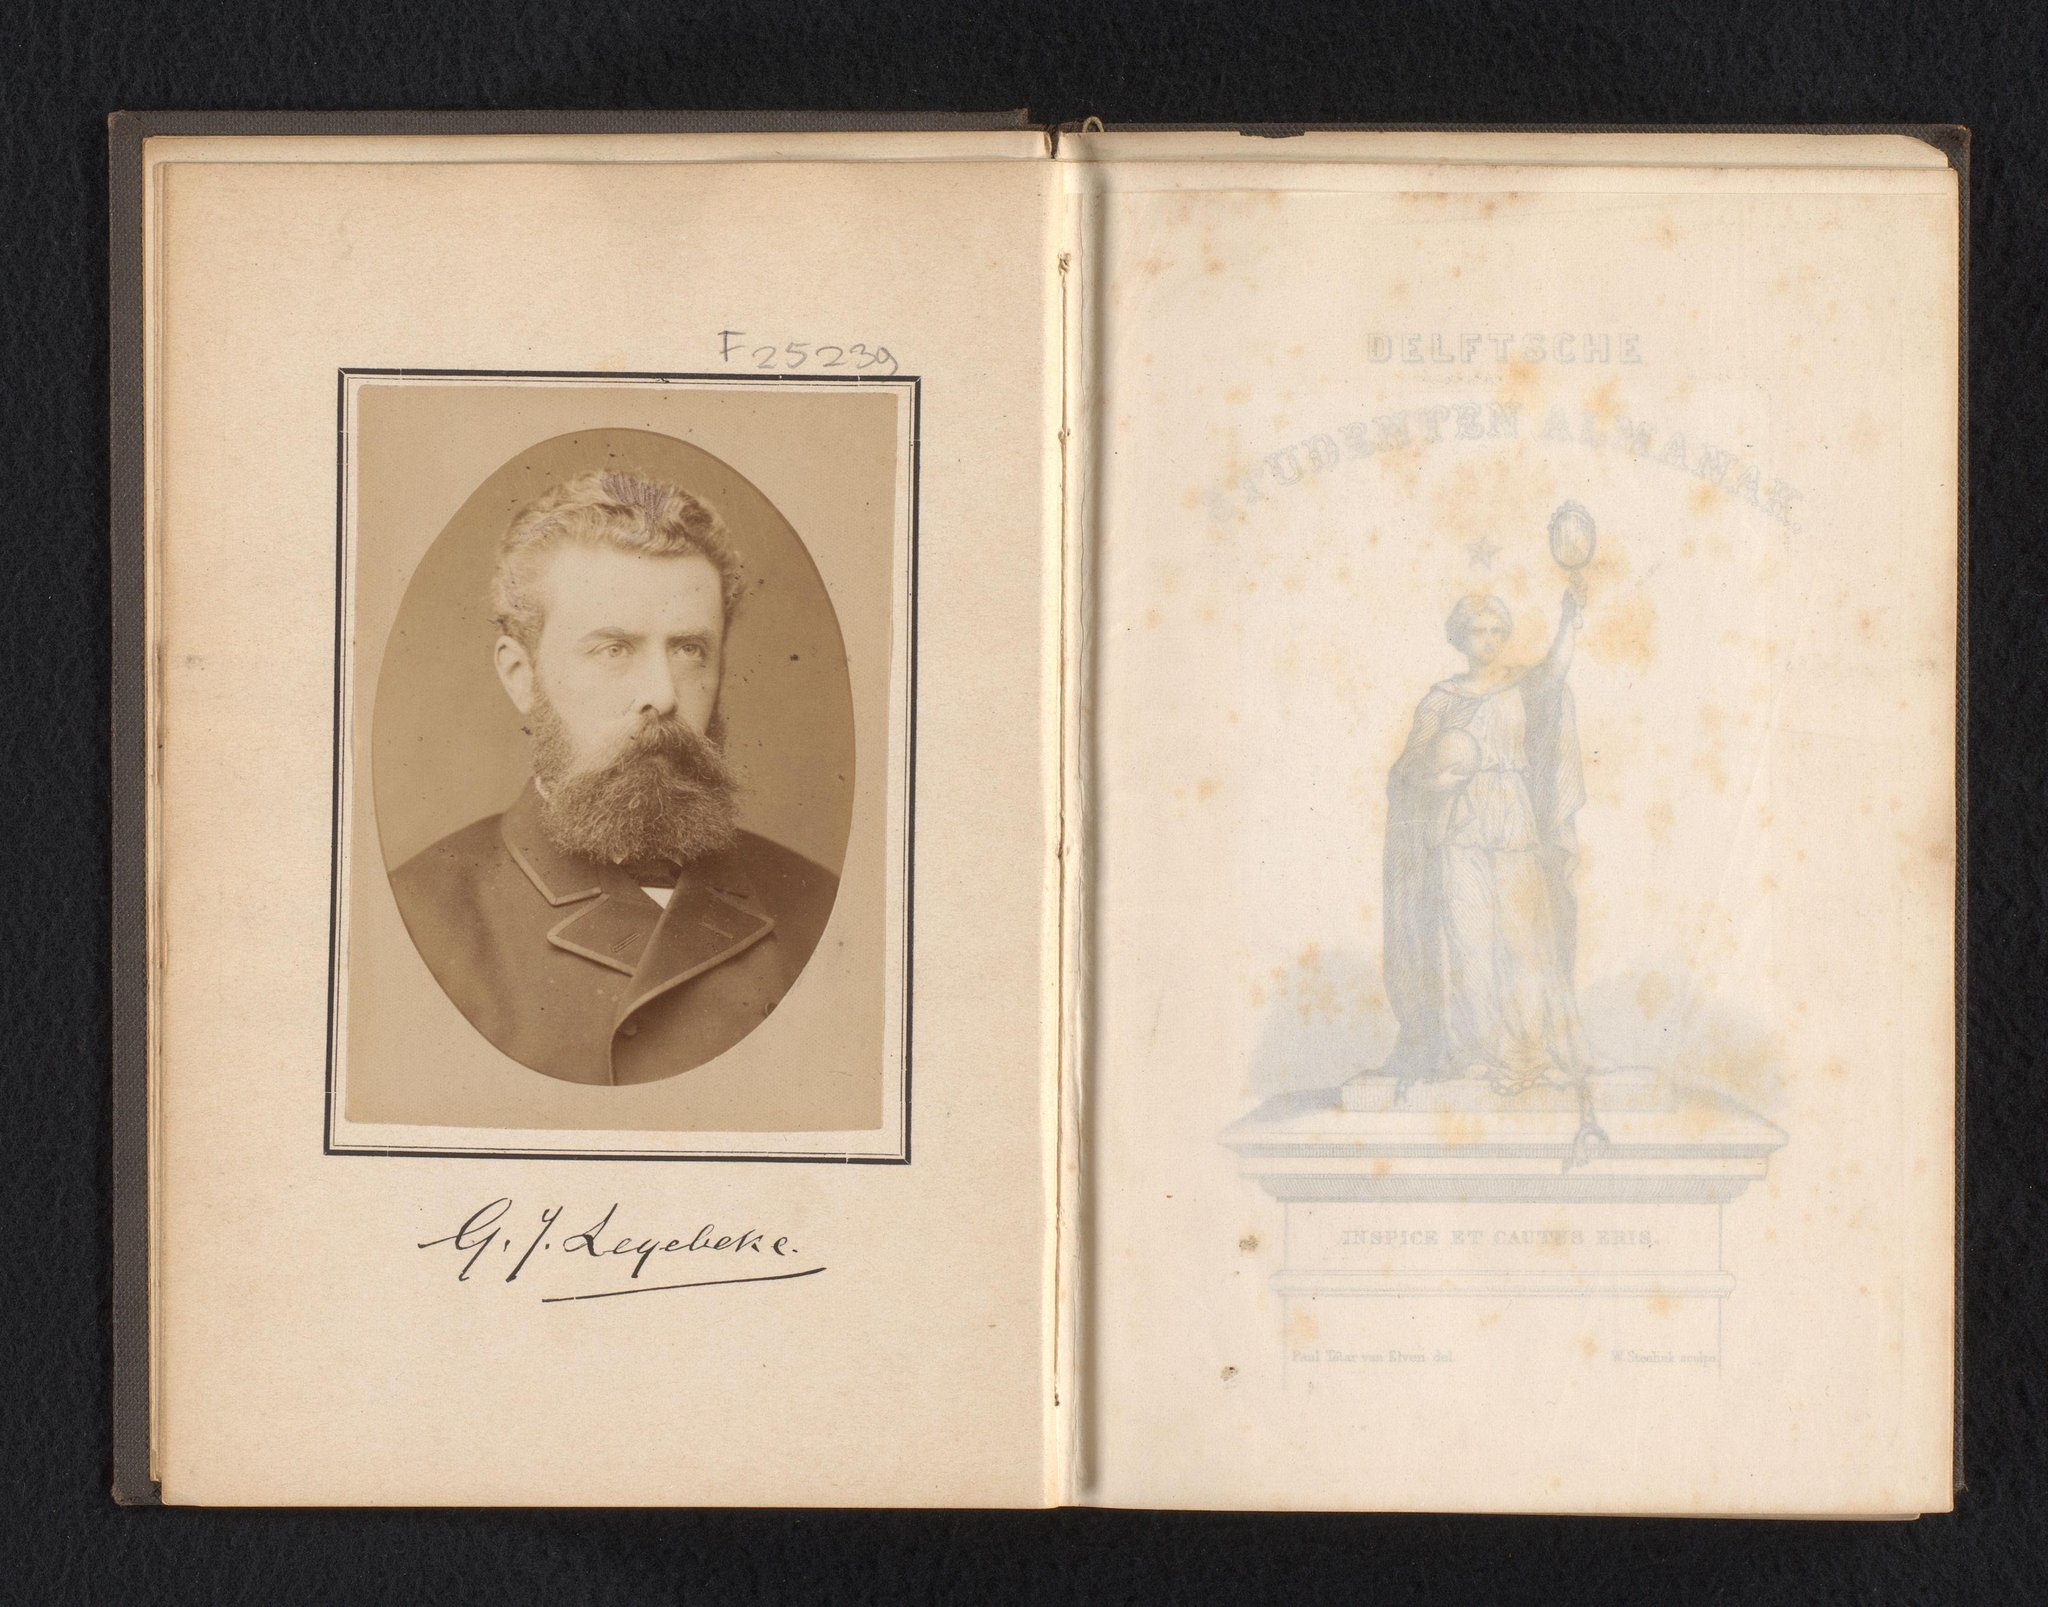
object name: photograph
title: Portret van G.J. Legebeke, hoogleraar in de zuivere en toegepaste wiskunde aan de Polytechnische School Delft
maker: Anonymous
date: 1885-1886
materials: paper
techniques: albumen print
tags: delft, historical persons, professor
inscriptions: signature: ‘G.J. Legebeke’